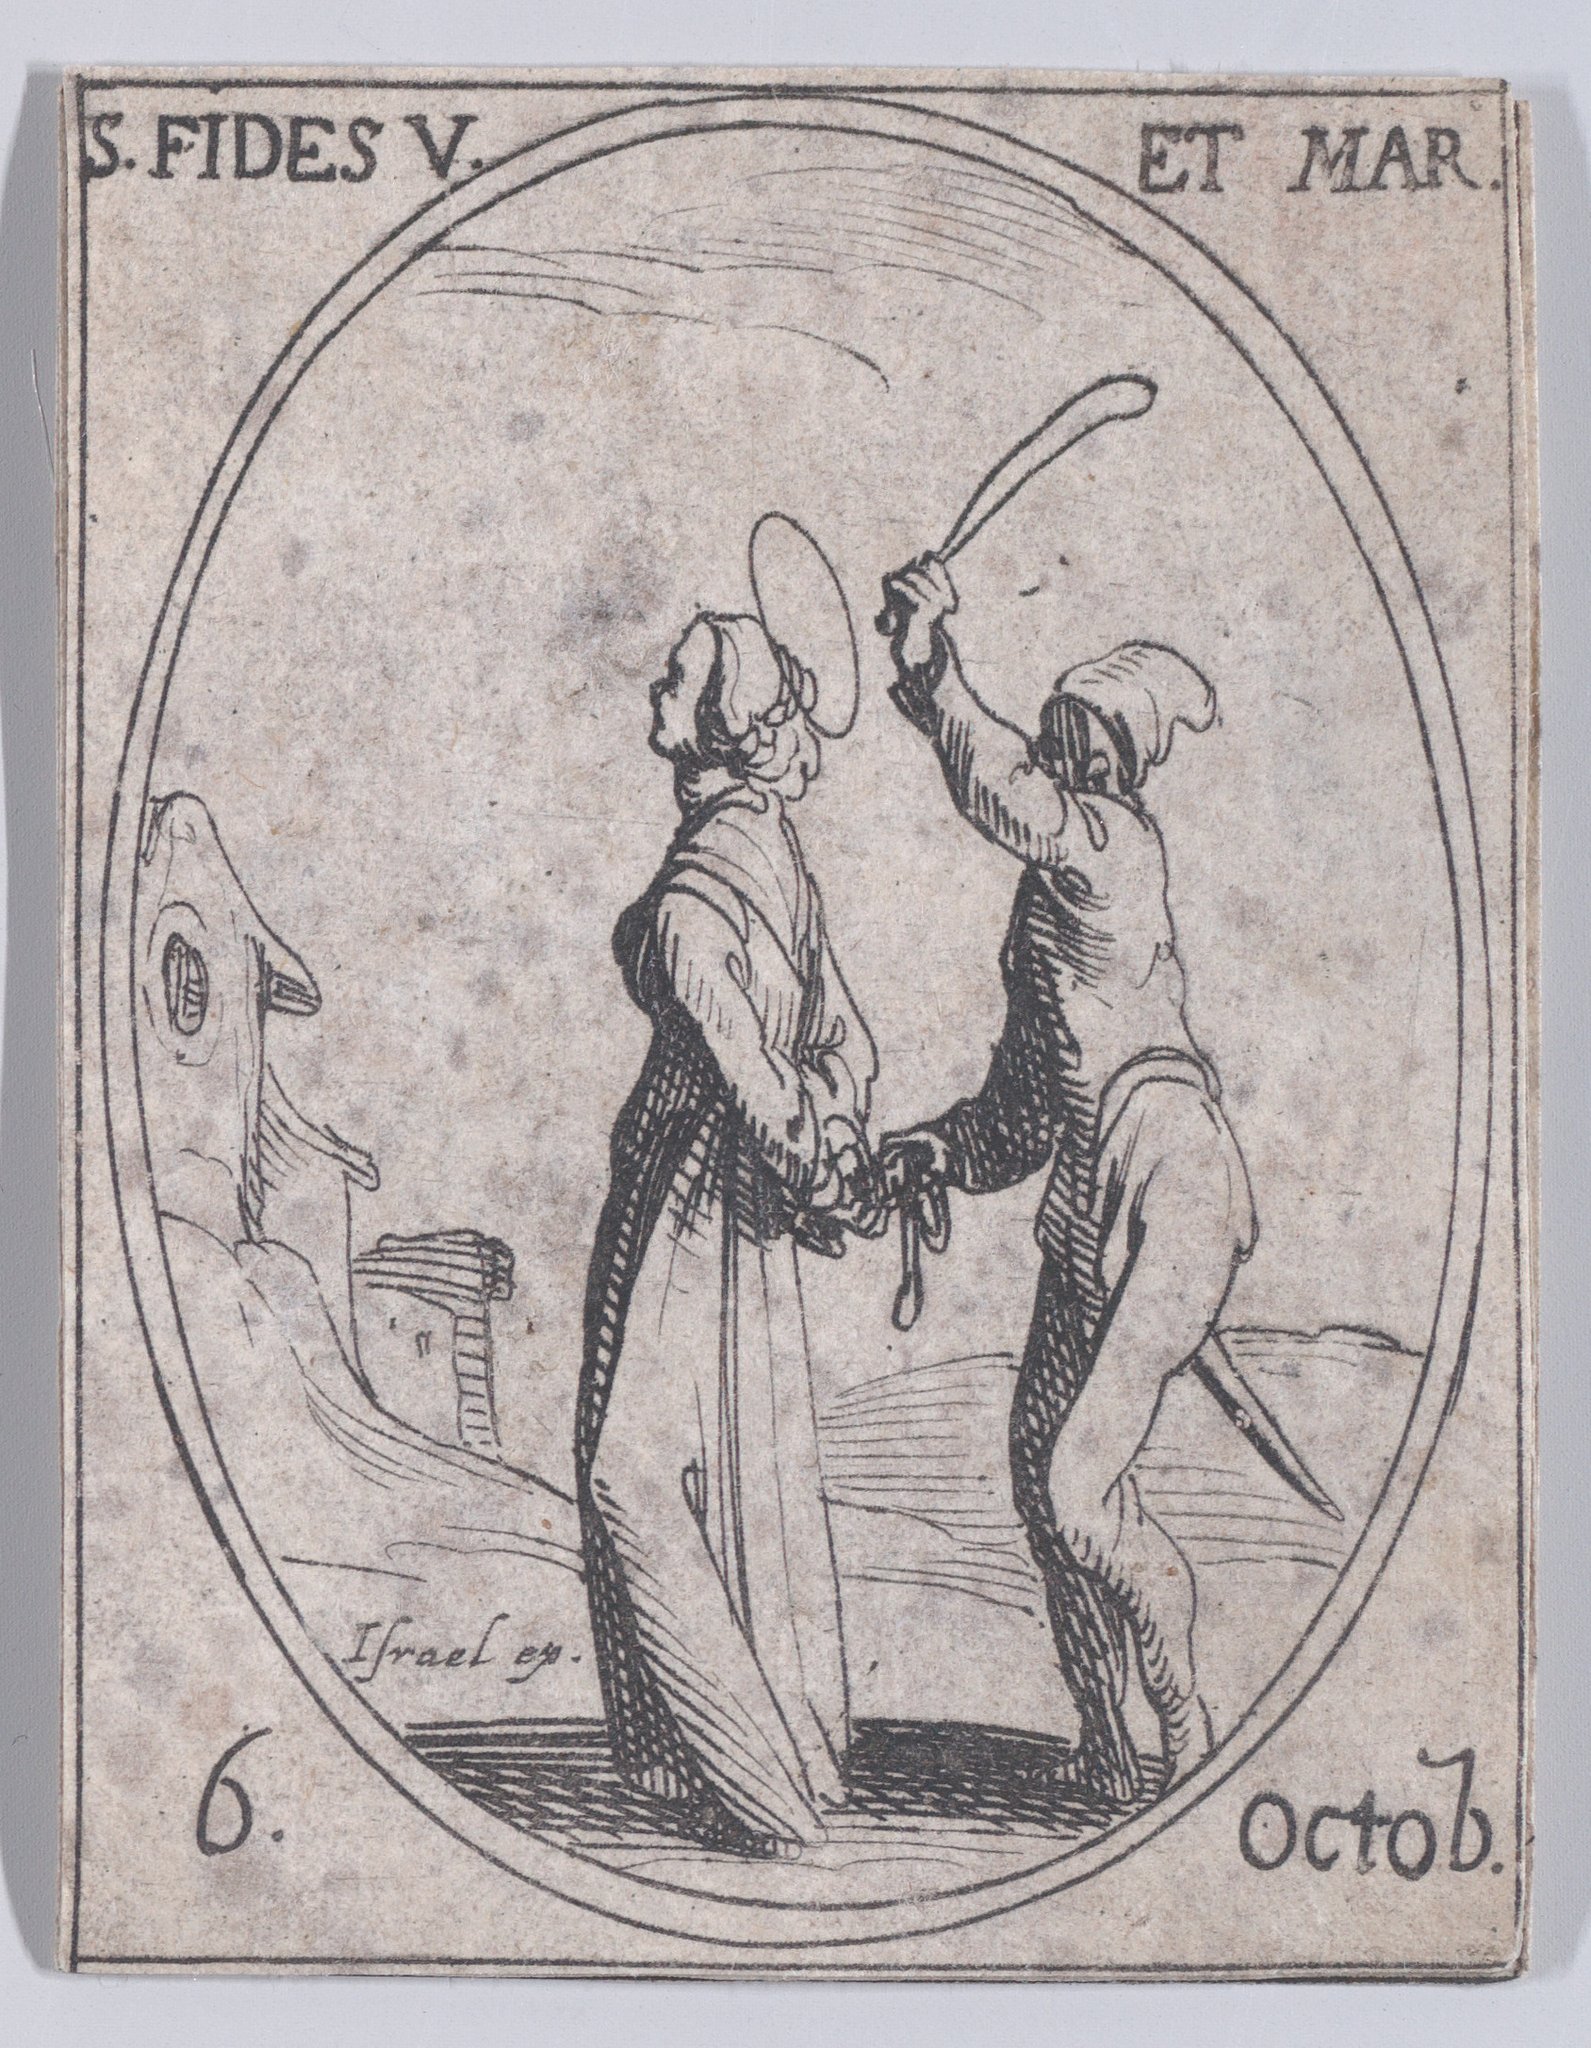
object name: print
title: Ste. Foi, vierge et martyre (St. Faith, Virgin and Martyr), October 6th, from "Les Images De Tous Les Saincts et Saintes de L'Année" (Images of All of the Saints and Religious Events of the Year)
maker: jacques callot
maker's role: artist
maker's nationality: french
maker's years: 1592-1635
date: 1636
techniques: etching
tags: men,women,saints